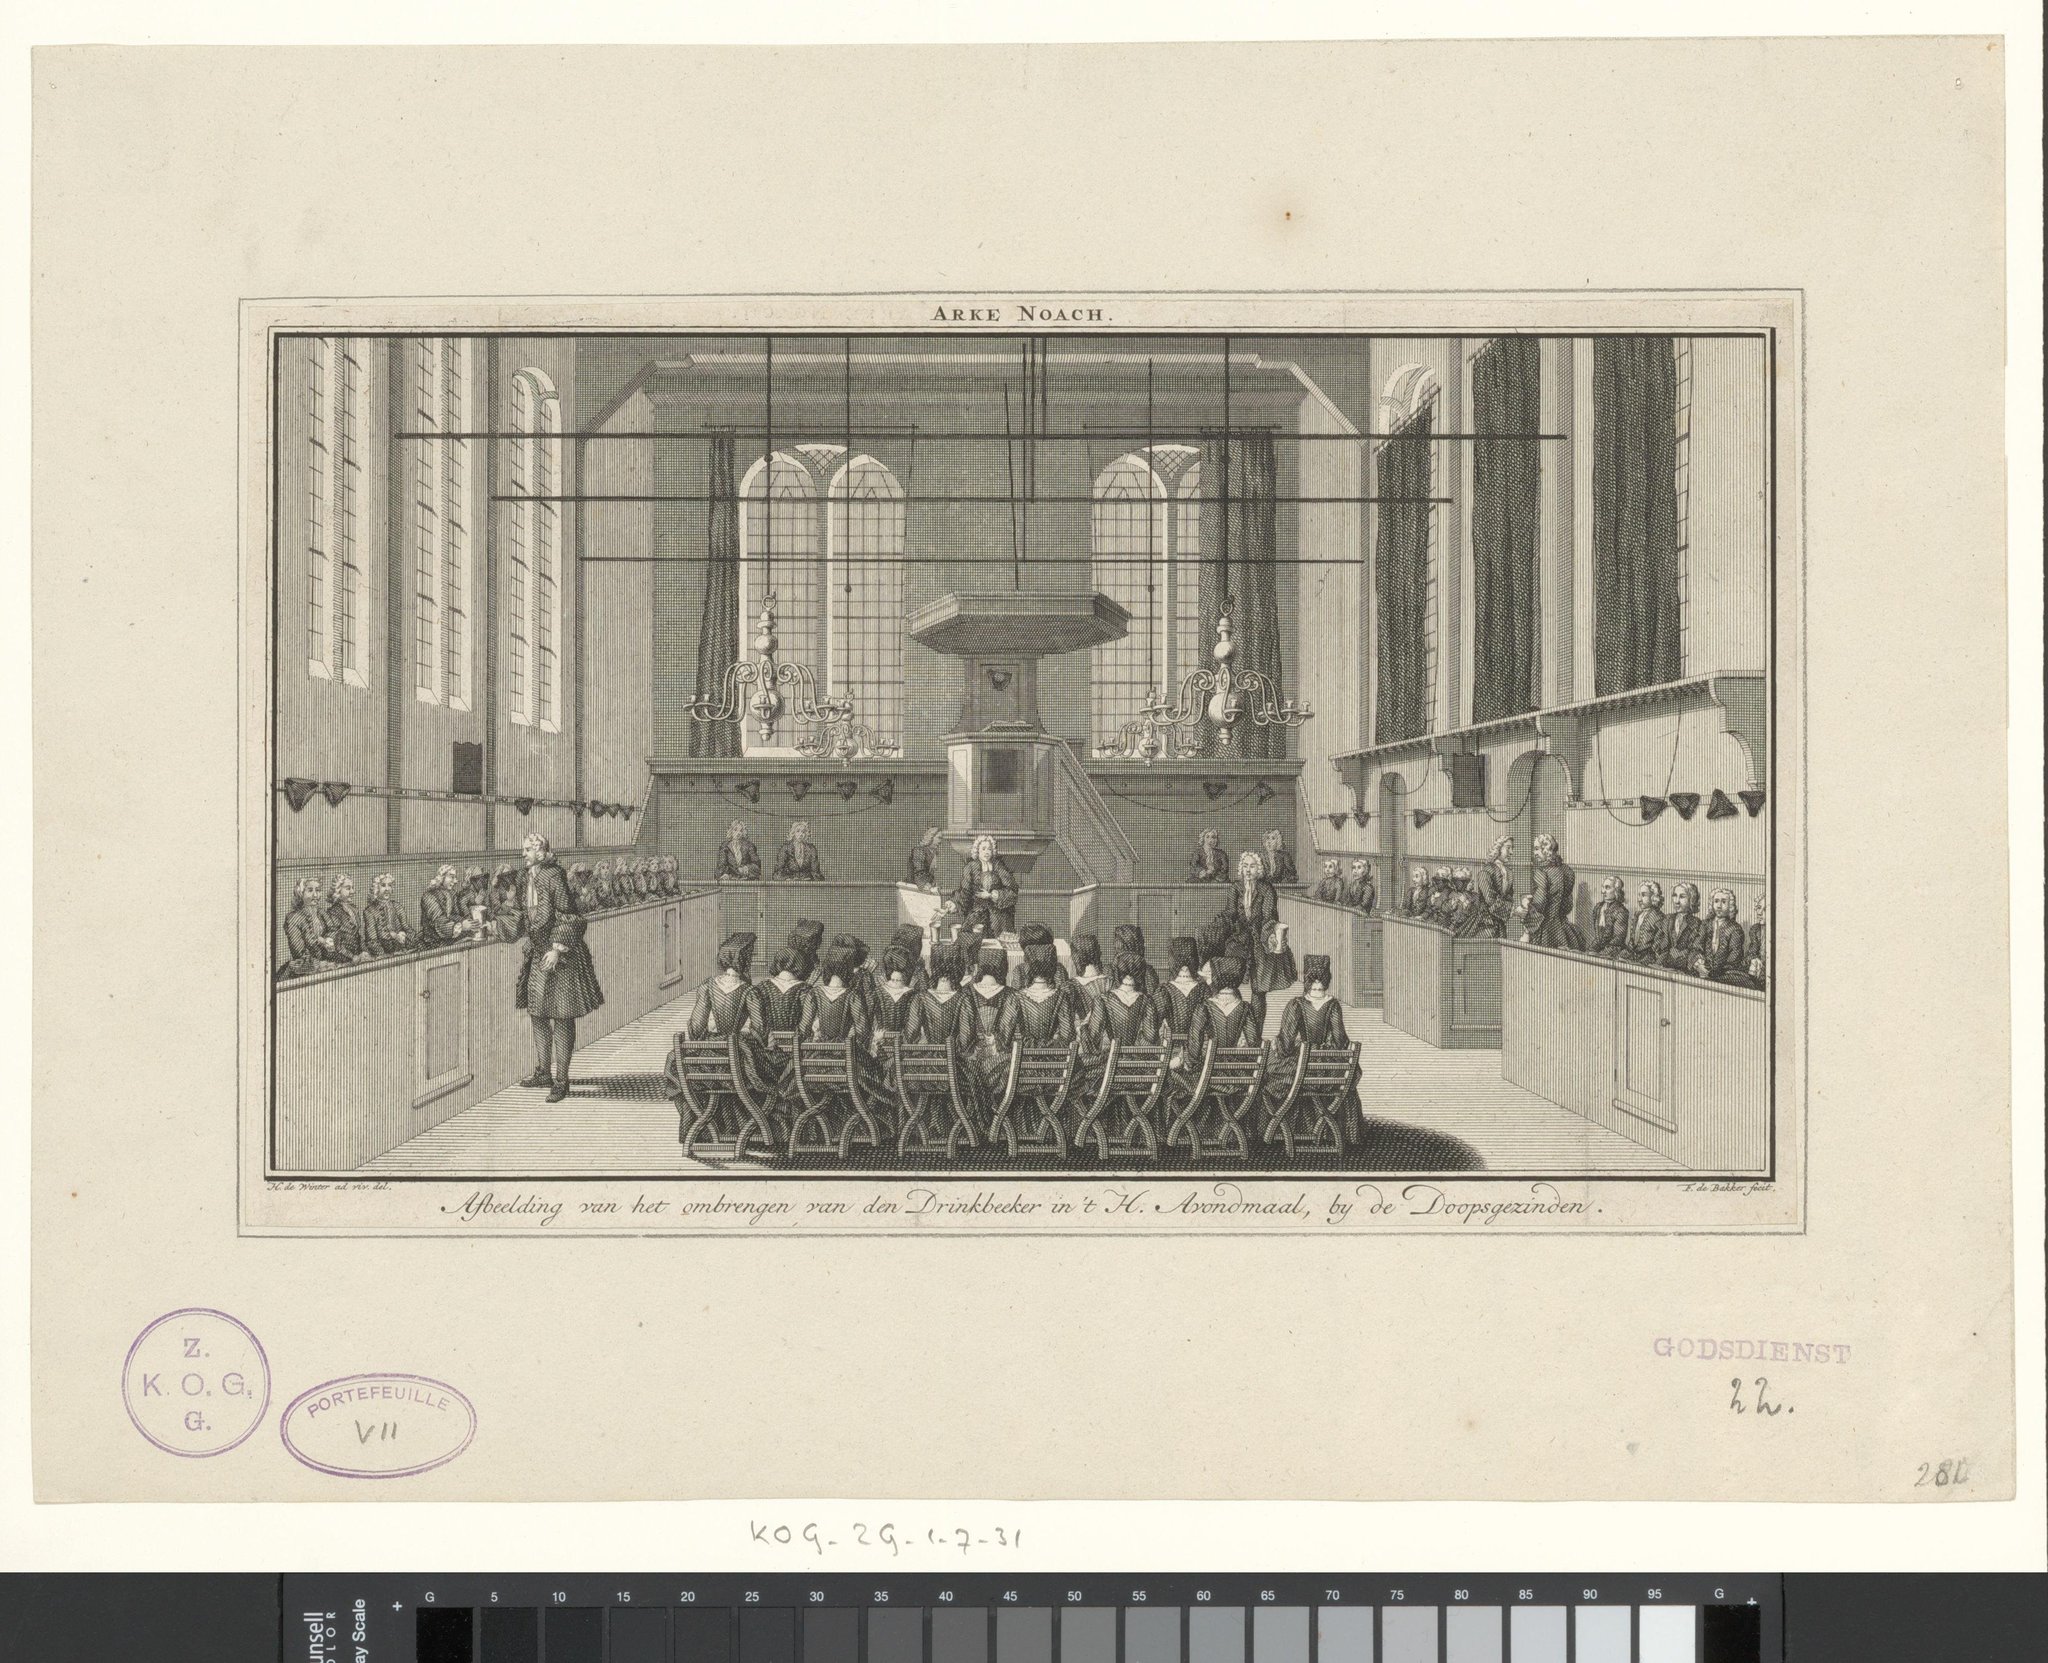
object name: print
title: Arke Noach. Afbeelding van het ombrengen van den Drinkbeeker in 't H. Avondmaal, by de Doopsgezinden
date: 1743-1750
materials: paper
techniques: engraving, etching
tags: protestant churches and denominations (mennonites), interior of church, holy communion ~ protestant service, amsterdam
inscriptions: collector's mark: Lugt 1641, stamp, stamp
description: Prent waarschijnlijk uit: Schijn, Hermannus. Geschiedenis dier christenen, welke in de Vereenigde Nederlanden onder de protestanten mennoniten genaamd worden (...). Amsterdam: Kornelis de Wit, 1743. Of uit: Maatschoen, G. Levensbeschryving van eenige voornaame mannen, in hun leven leeraaren, by de Doopsgezinden (...). Amsterdam: Kornelis de Wit, 1750.